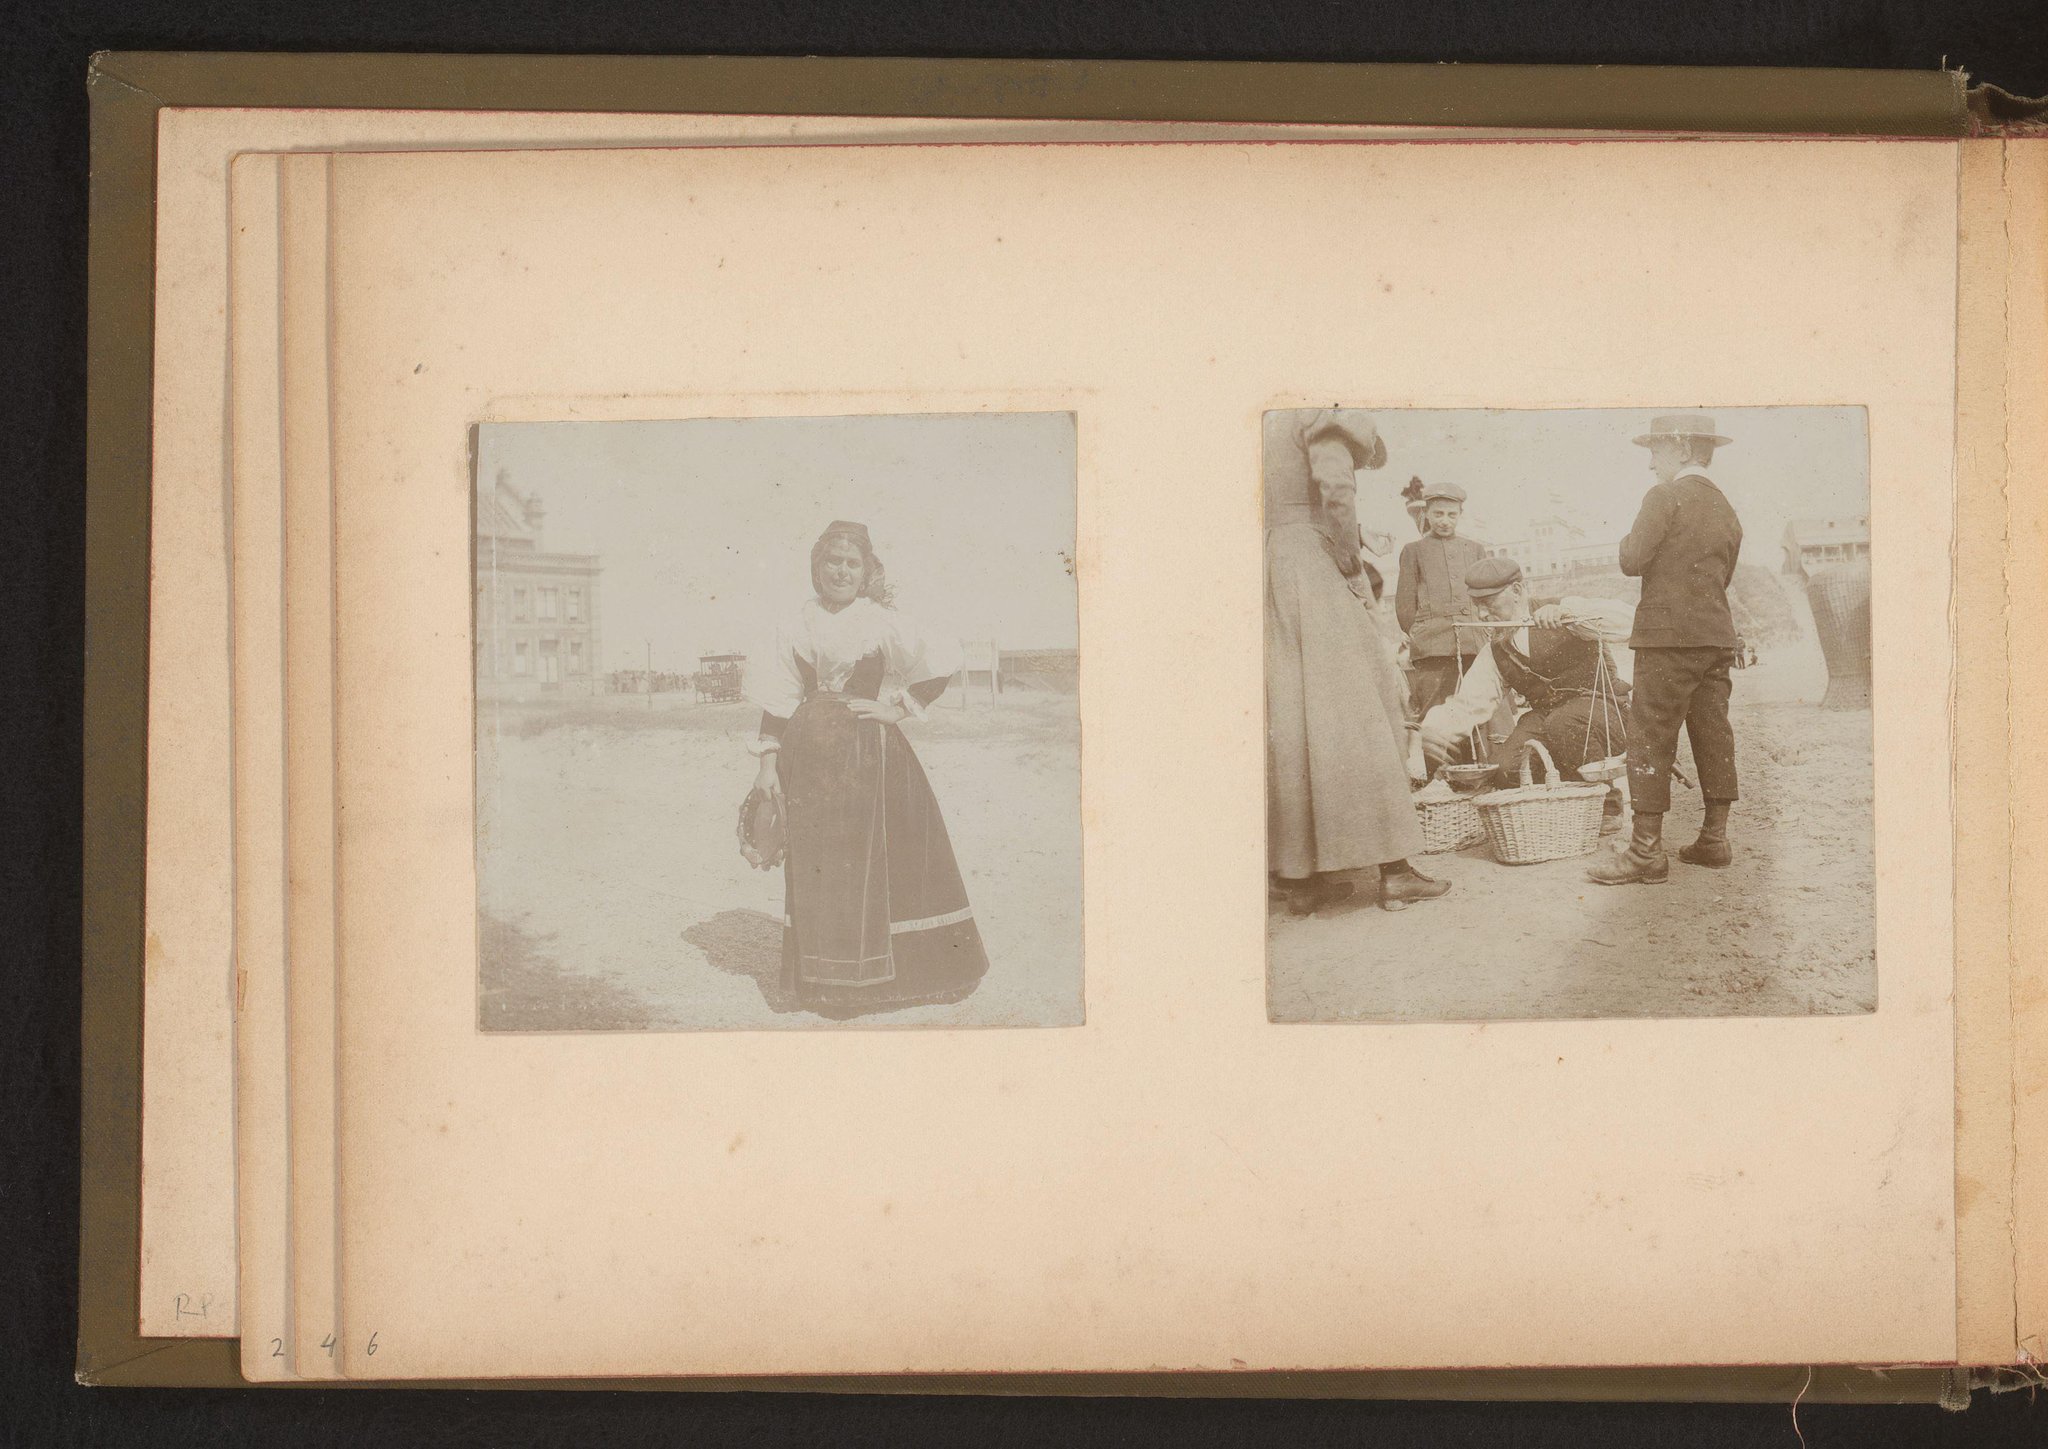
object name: photograph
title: Twee foto's van een vrouw met een tamboerijn en een straatverkoper met een weegschaal, Zandvoort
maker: Anonymous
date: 1895-1910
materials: paper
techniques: collodion silver print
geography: zandvoort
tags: tambourine, scales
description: Deze foto's maken deel uit van een album.